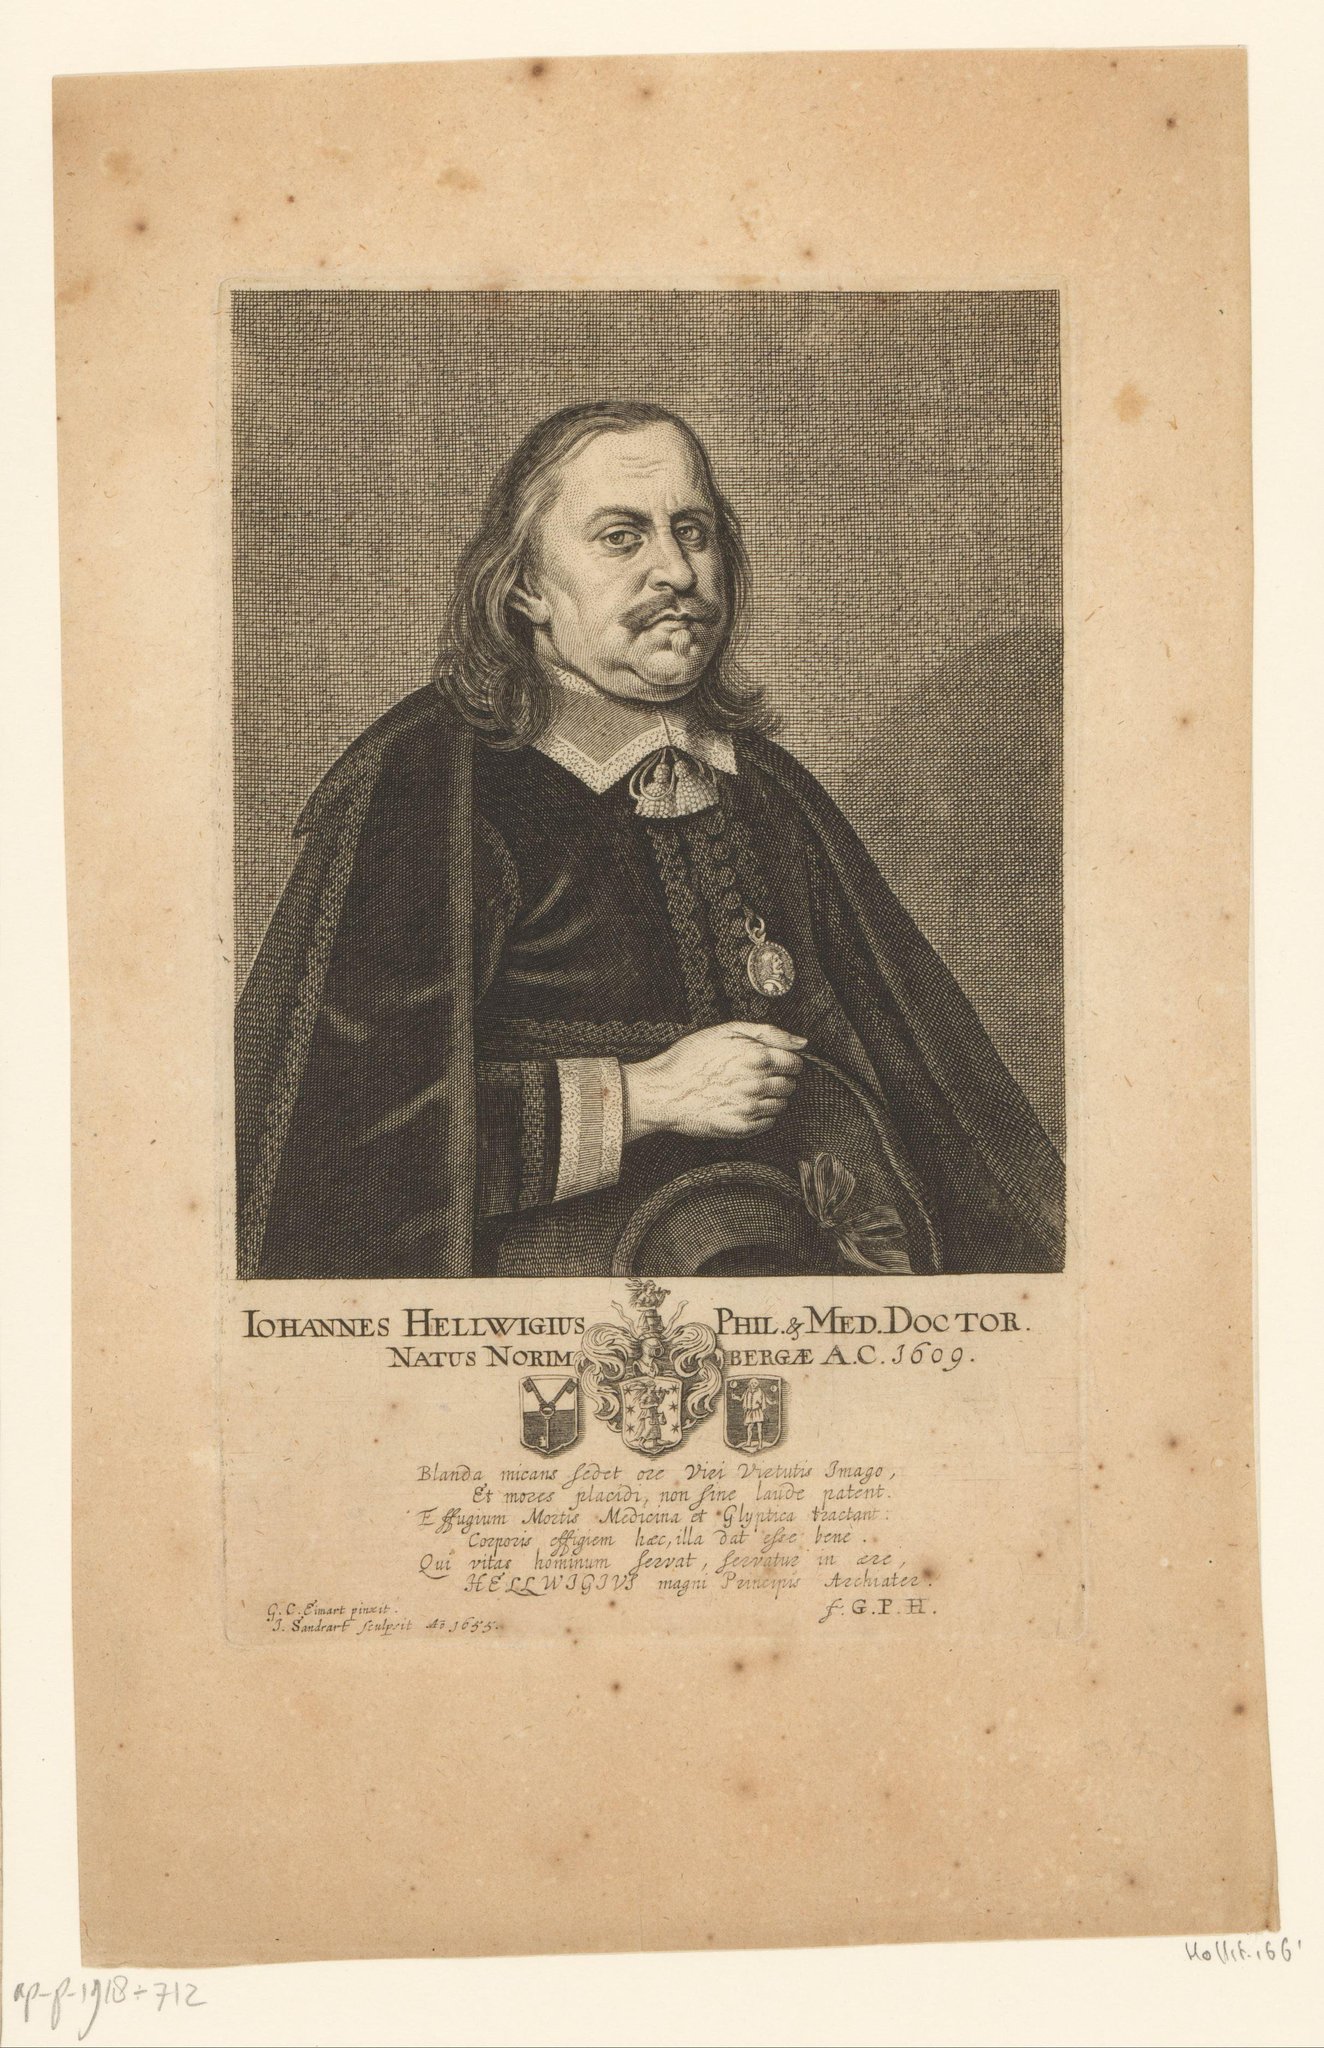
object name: print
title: Portret van Johann Hellwig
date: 1655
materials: paper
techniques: engraving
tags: johann hellwig, historical persons, pendant, trinket, 'breloque', armorial bearing, heraldry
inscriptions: collector's mark: Lugt 2228